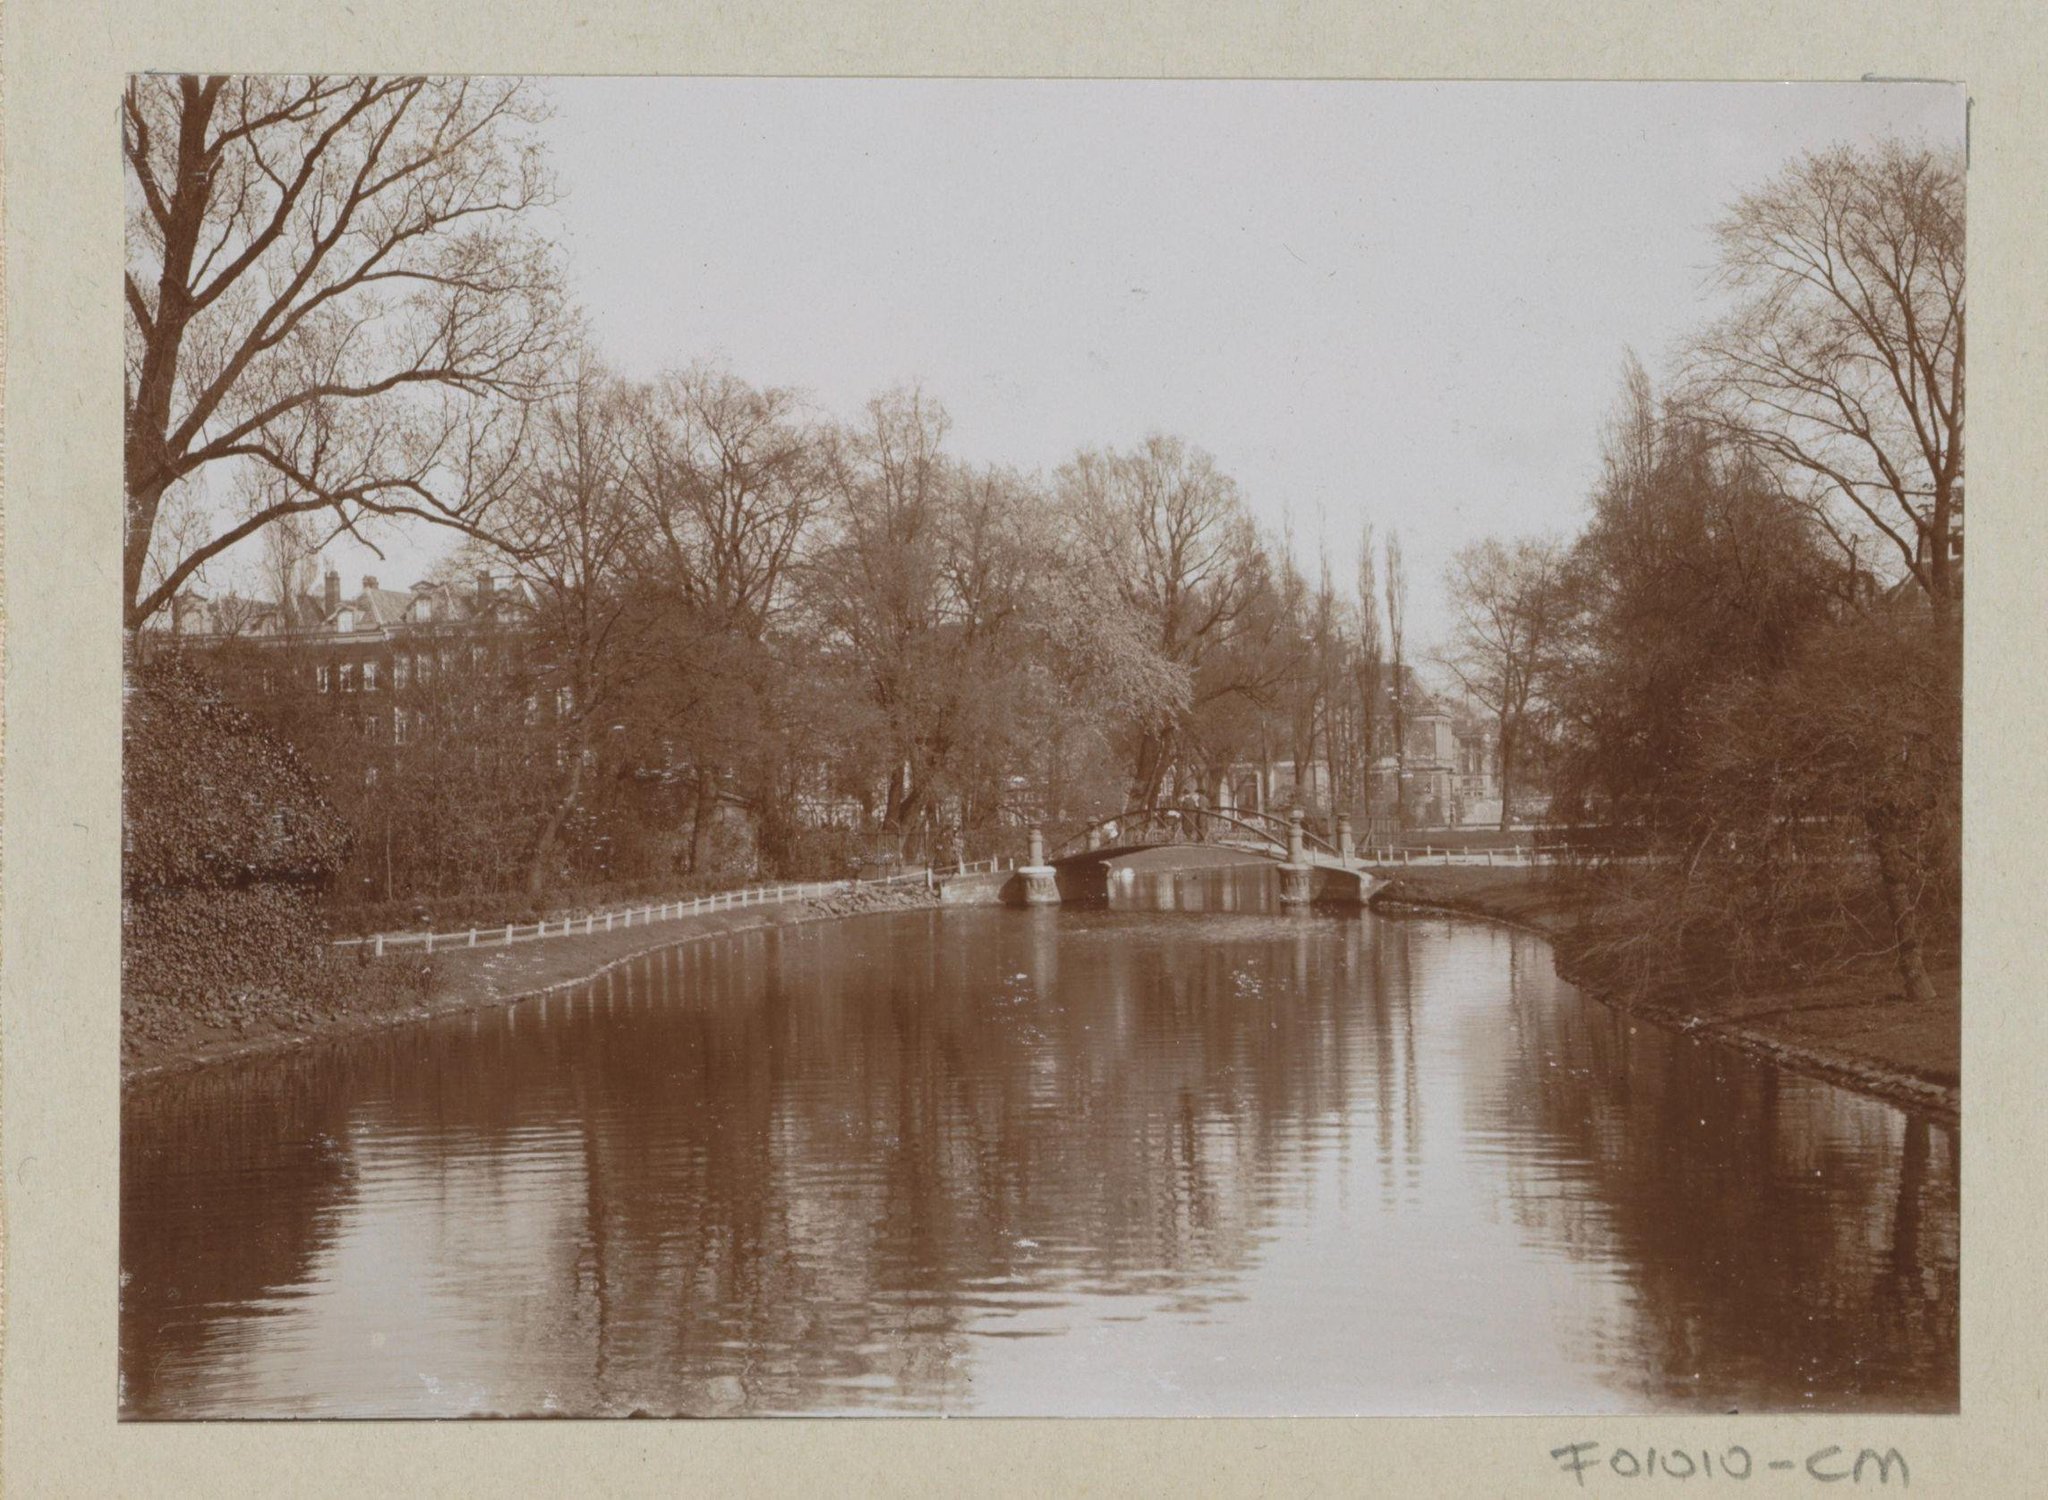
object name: photograph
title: Gezicht op de vijver van het Hortusplantsoen te Amsterdam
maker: Anonymous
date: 1900-1910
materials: photographic support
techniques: collodion silver print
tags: pond, bridge, public gardens, park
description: Onderdeel van Familiealbum met onder meer foto's van Wijnhandel Kraaij & Co. Bordeaux-Amsterdam.